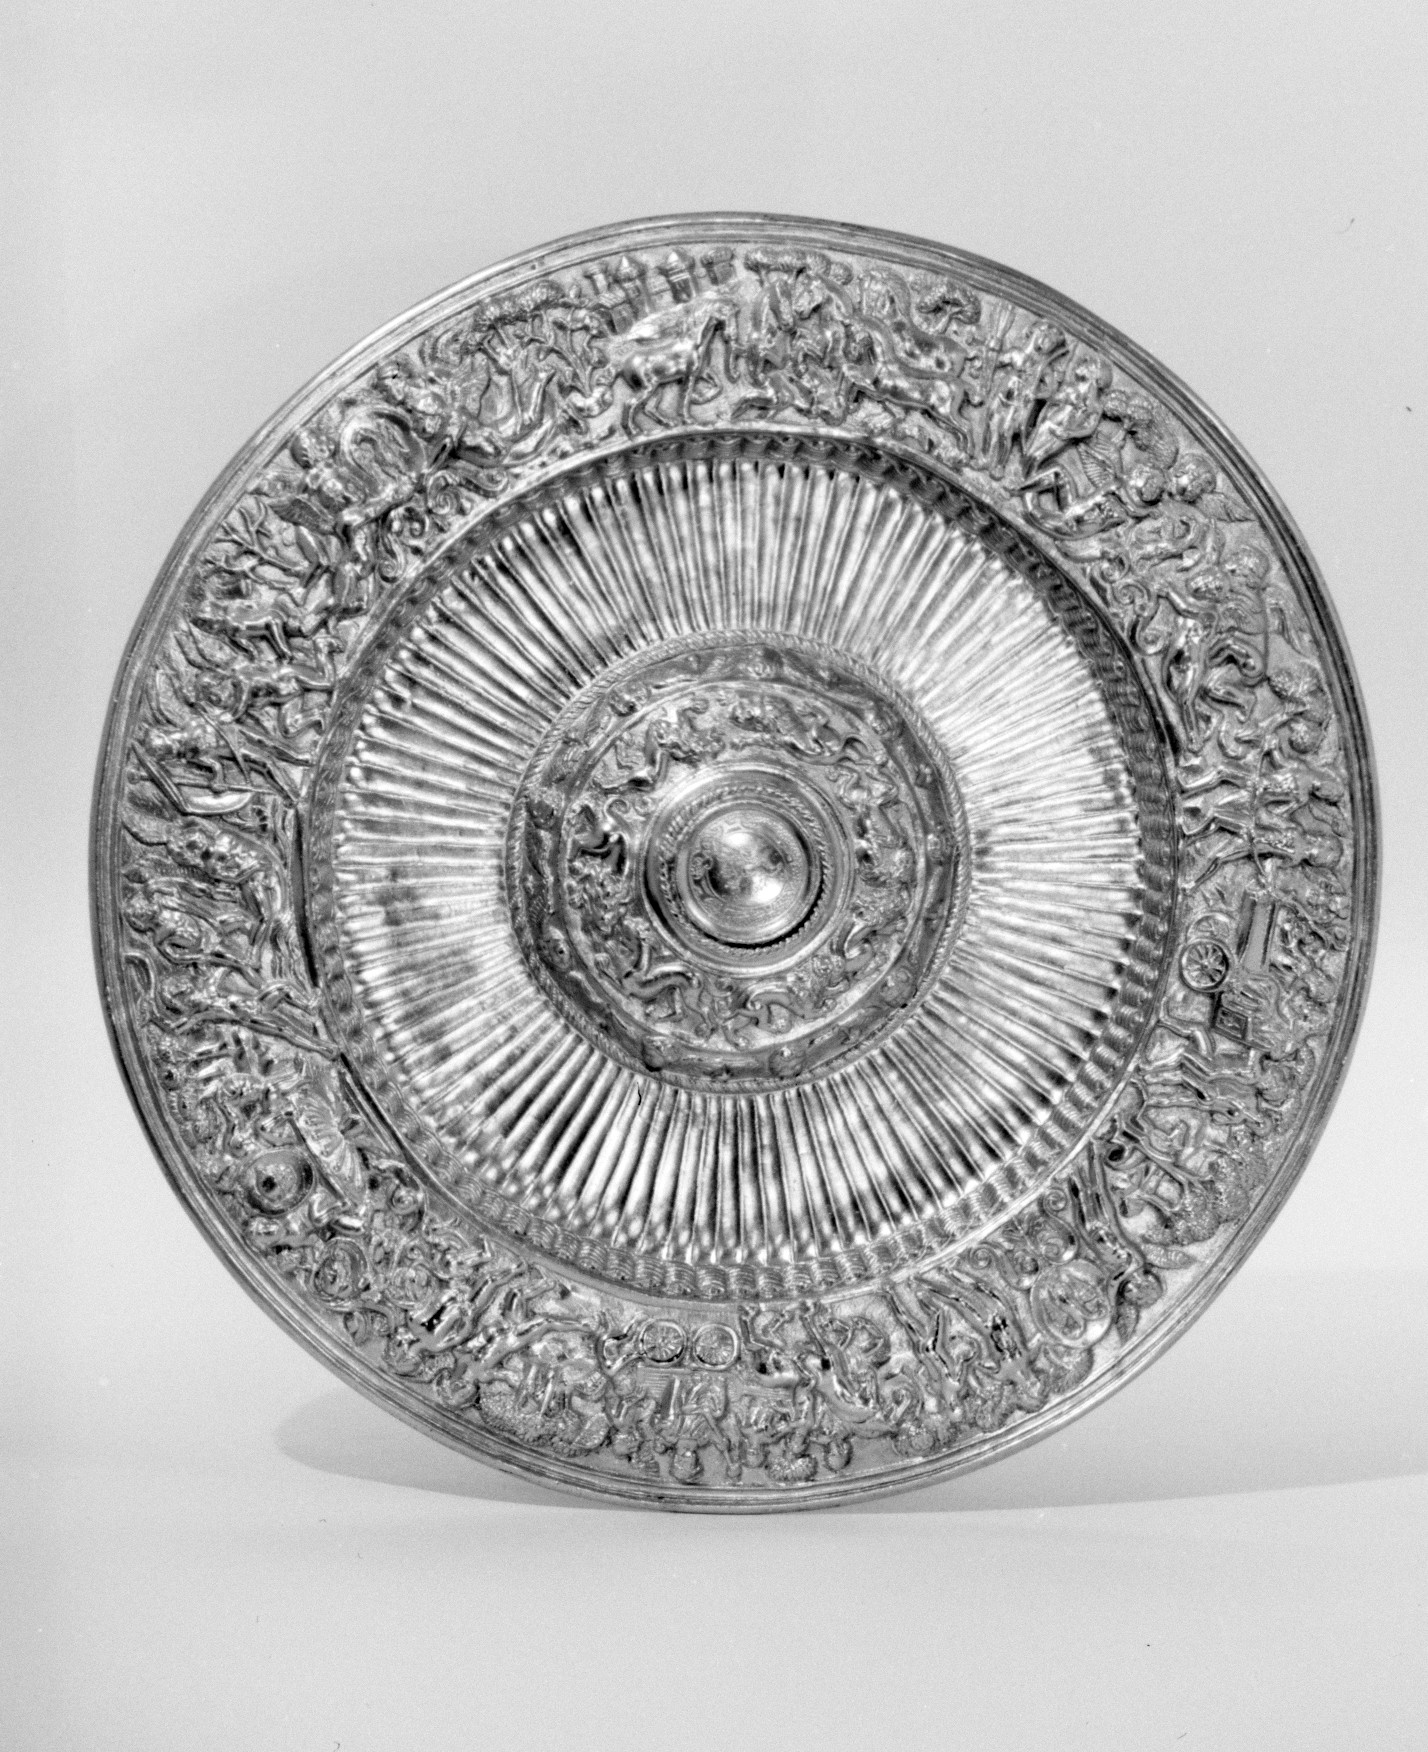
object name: salver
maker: franchi and son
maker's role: manufacturer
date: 1801-1900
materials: metal, silver